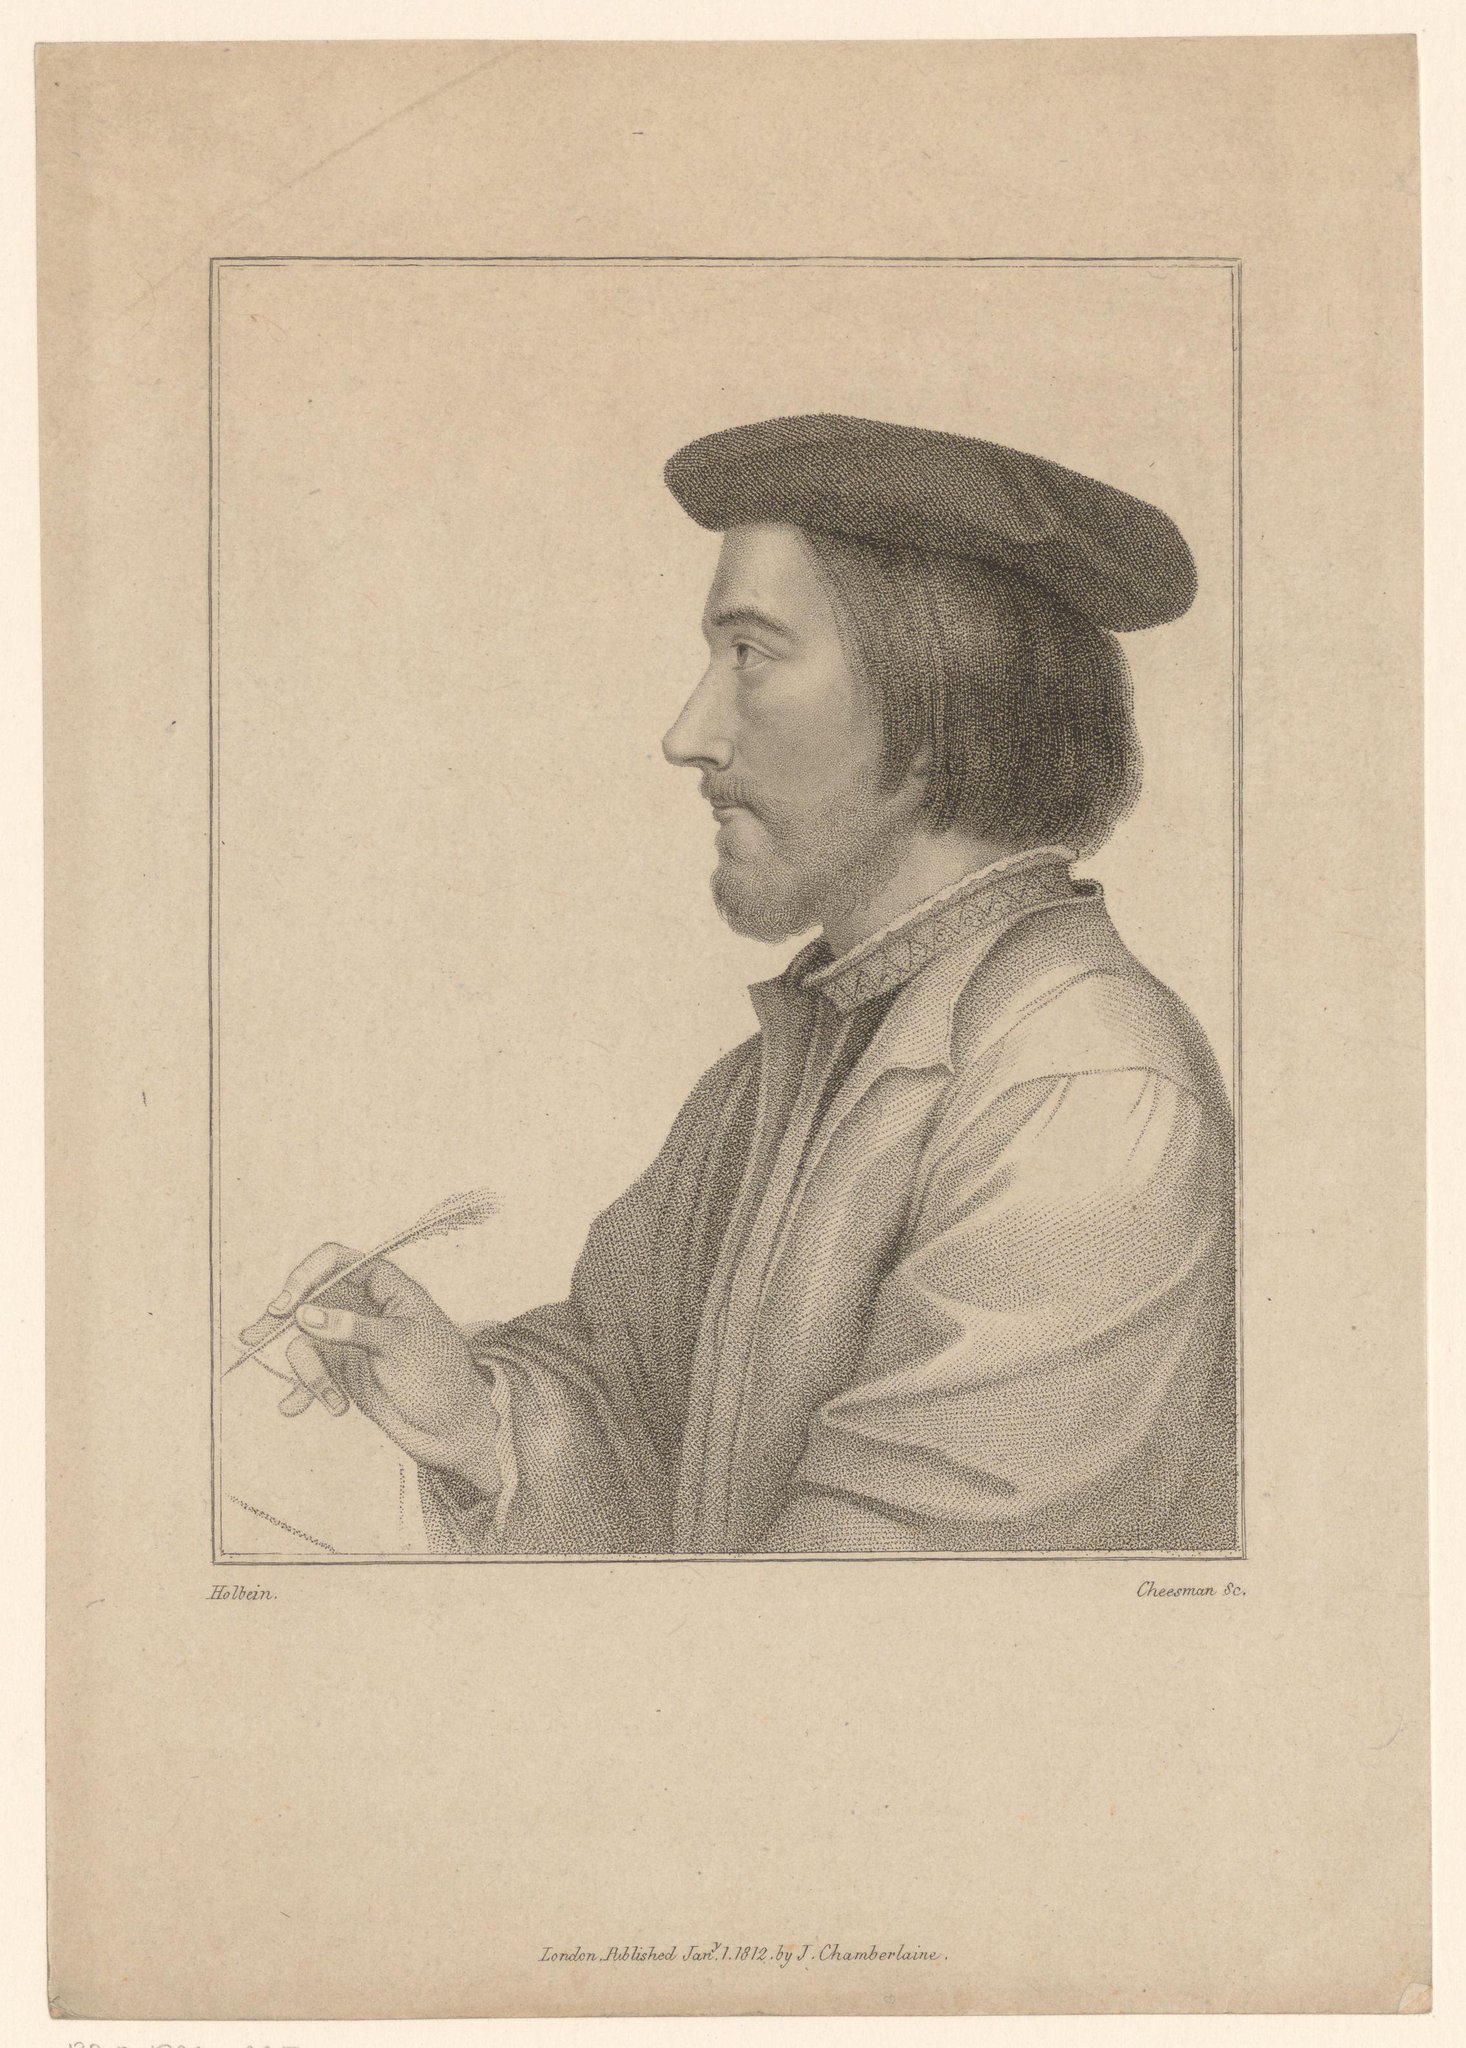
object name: print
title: Portret van Nicolas Bourbon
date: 1812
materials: paper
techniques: stippling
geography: london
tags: paris, historical persons, writer, poet, author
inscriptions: collector's mark: Lugt 2228